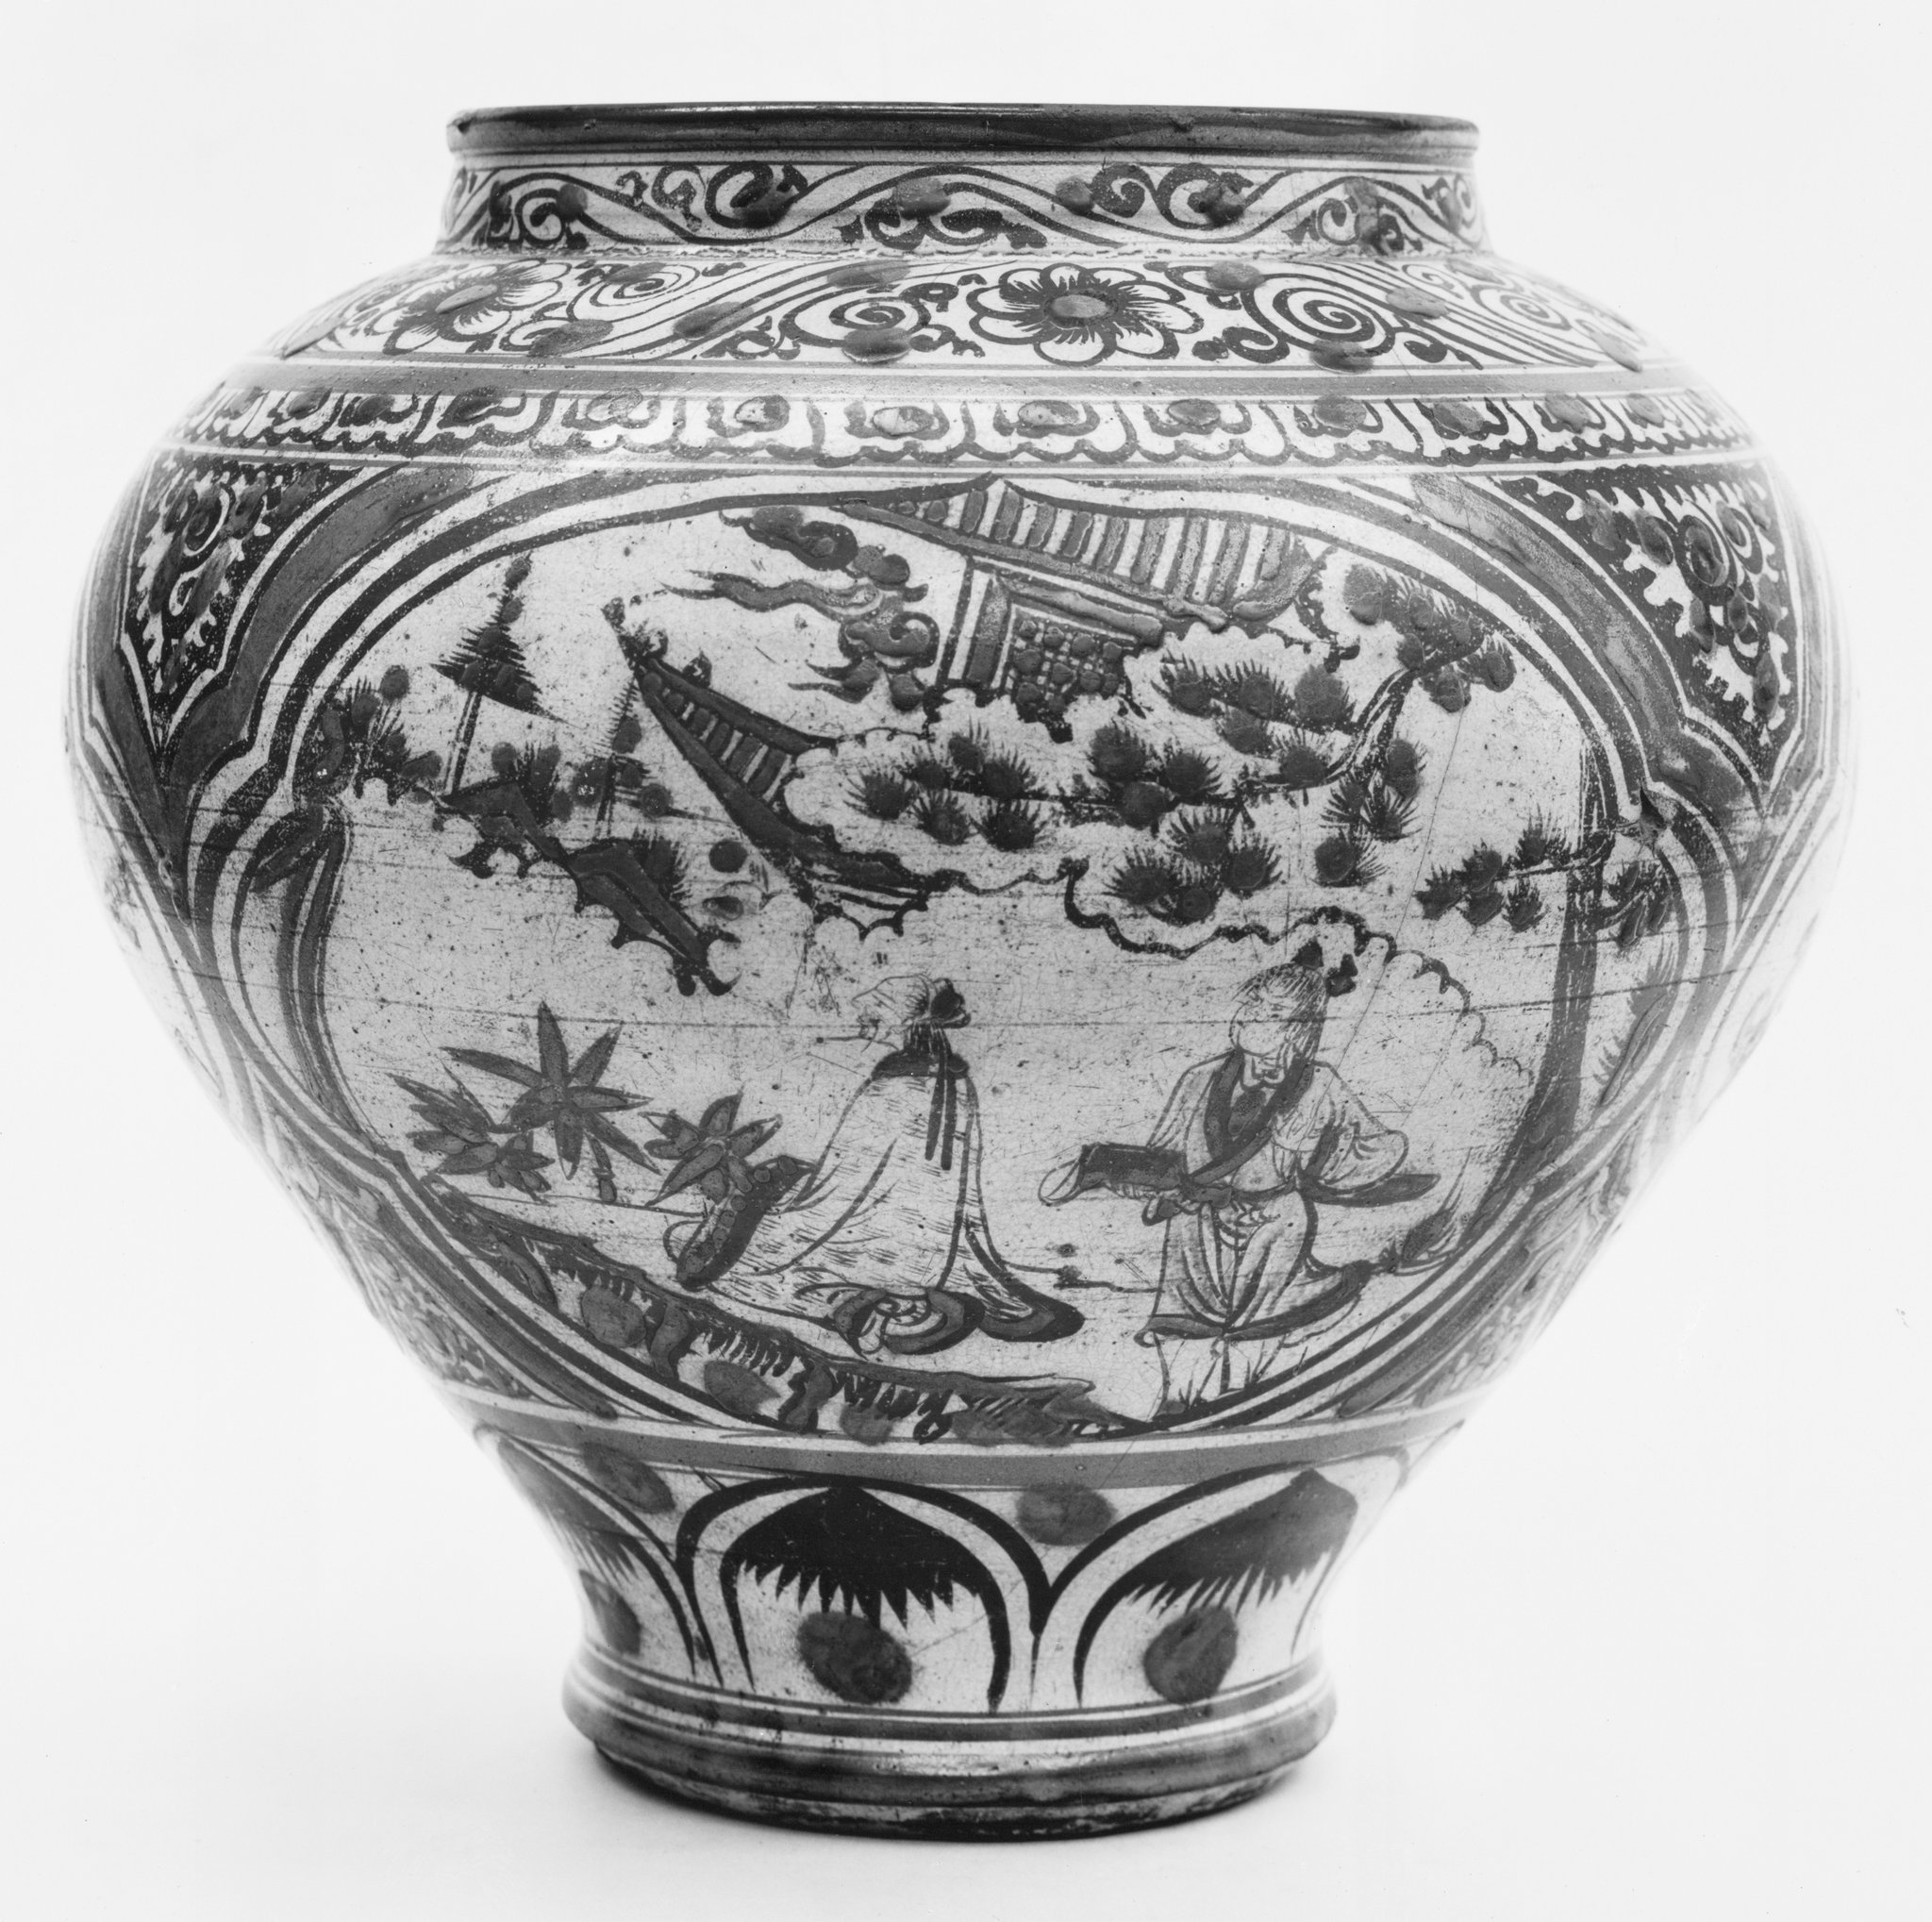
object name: jar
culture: chinese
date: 1334-1366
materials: enamel, stoneware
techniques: overglaze, painting, underglaze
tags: human figures,flowers,trees